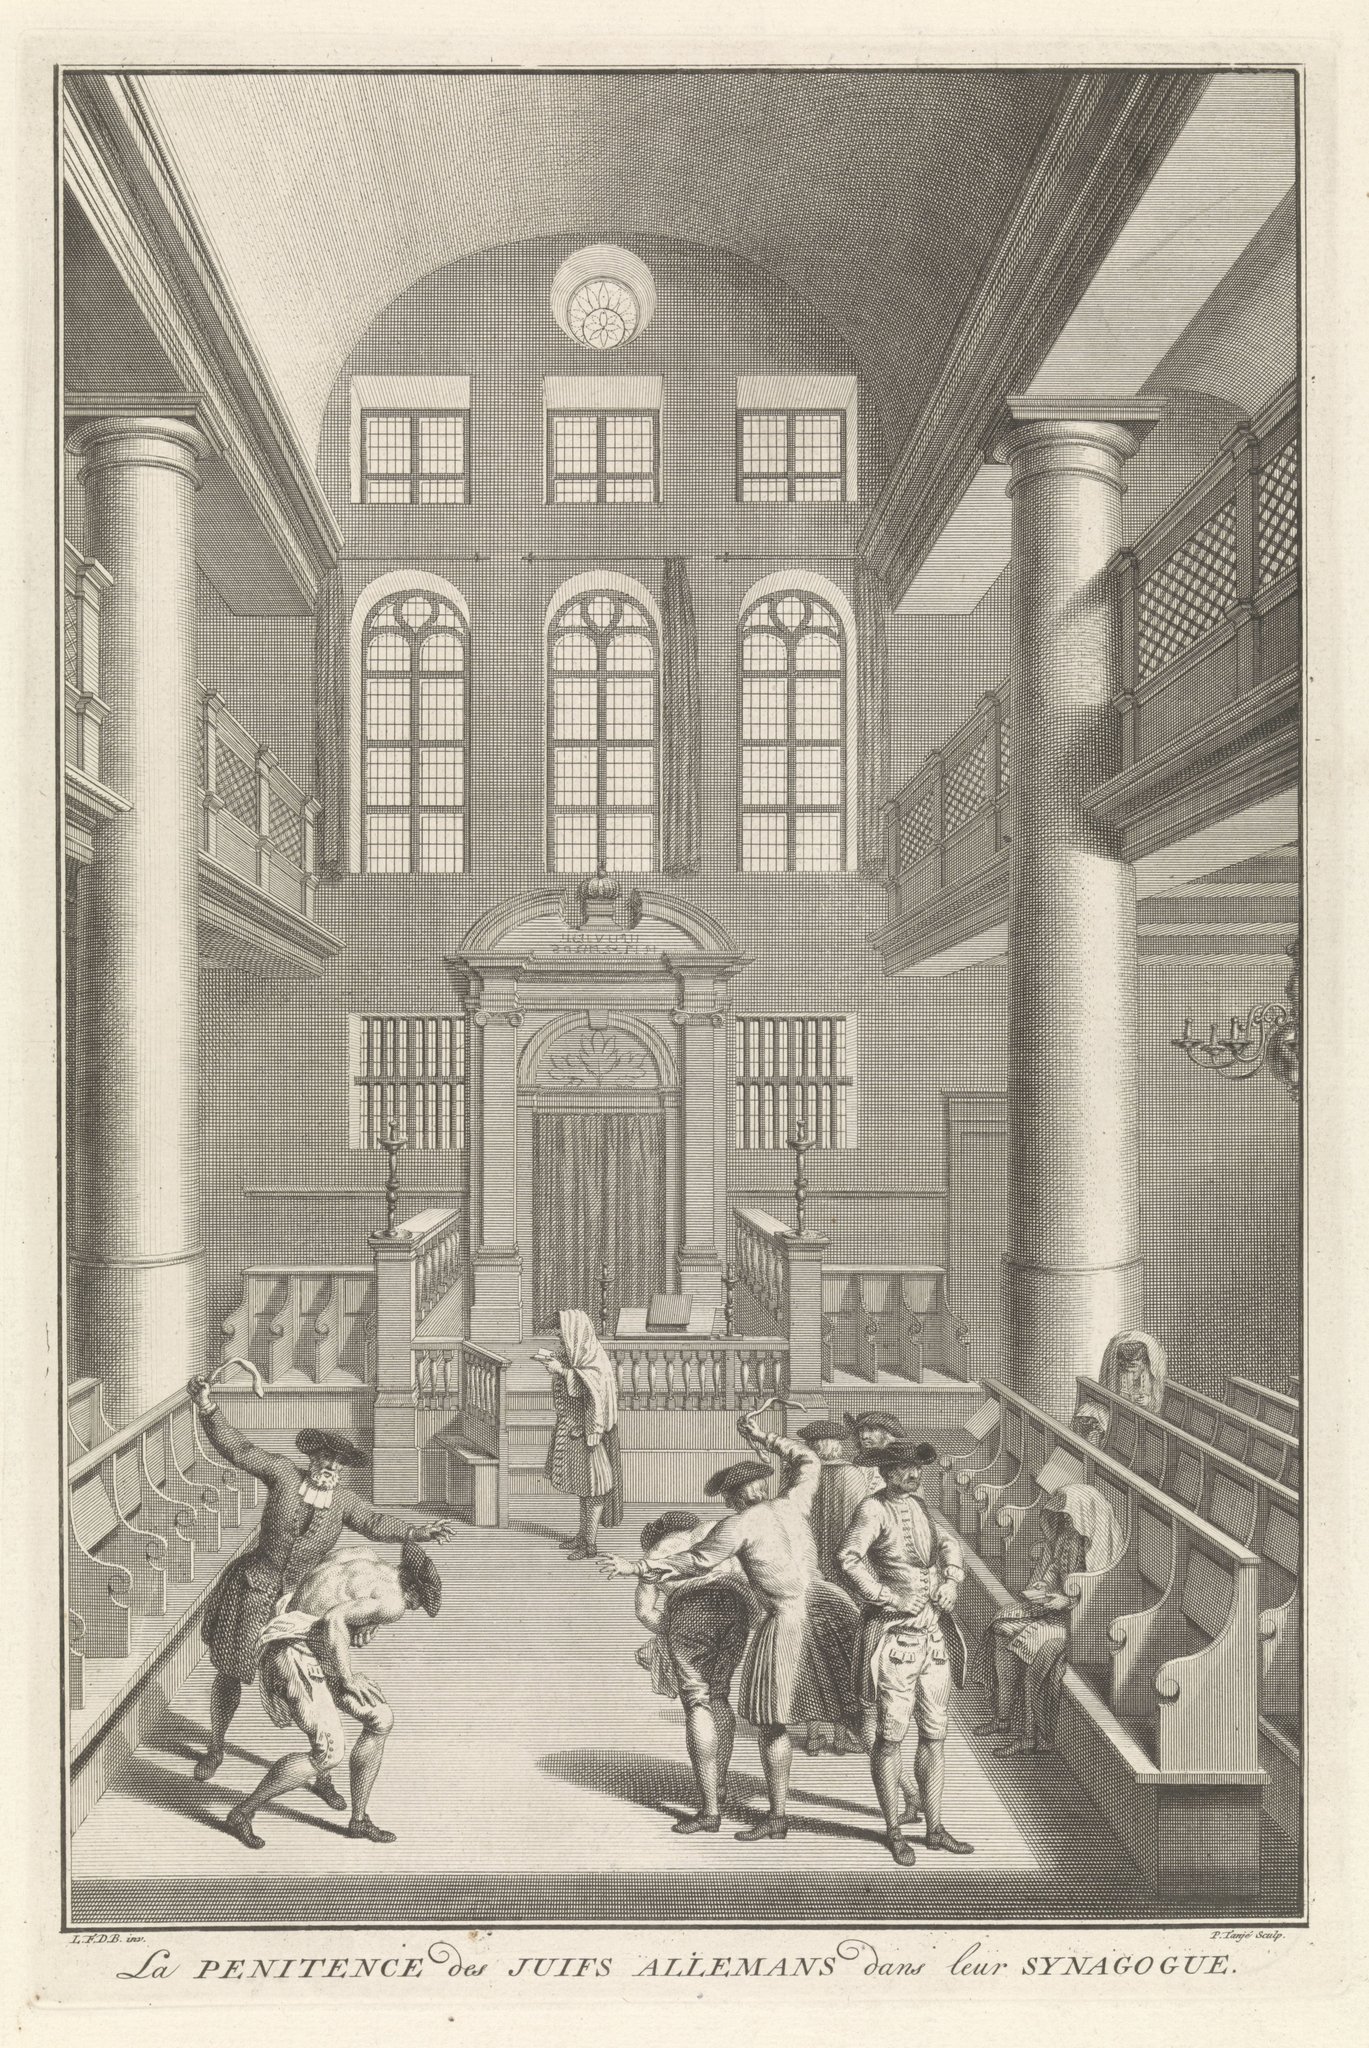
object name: book illustration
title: Boetedoening door Asjkenazische Joden in de synagoge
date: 1716-1761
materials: paper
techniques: engraving, etching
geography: amsterdam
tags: 'malkot', crouching men beaten with straps ~ 'yom kippur', additional service in the synagogue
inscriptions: collector's mark: Lugt 240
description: Prent gebruikt in: Picart, Bernard. Ceremonies et coutumes religieuses de tous les peuples du monde (...). Tome cinquieme, qui contient les cérémonies des mahometans &c. Deel 5. Amsterdam: Jean Frederic Bernard, 1737, na p. 12. Prent gebruikt in: Picart, Bernard. Naaukeurige beschryving der uitwendige godtsdienst-plichten, kerk-zeden en gewoontens van alle volkeren der waereldt, deel 6. [Vertaald uit het Frans door] Abraham Moubach. Amsterdam: Hermannus Uytwerf, Rotterdam: Jan Daniel Beman, Den Haag: Isaac van der Kloot, 1727-1738, na p. 298.